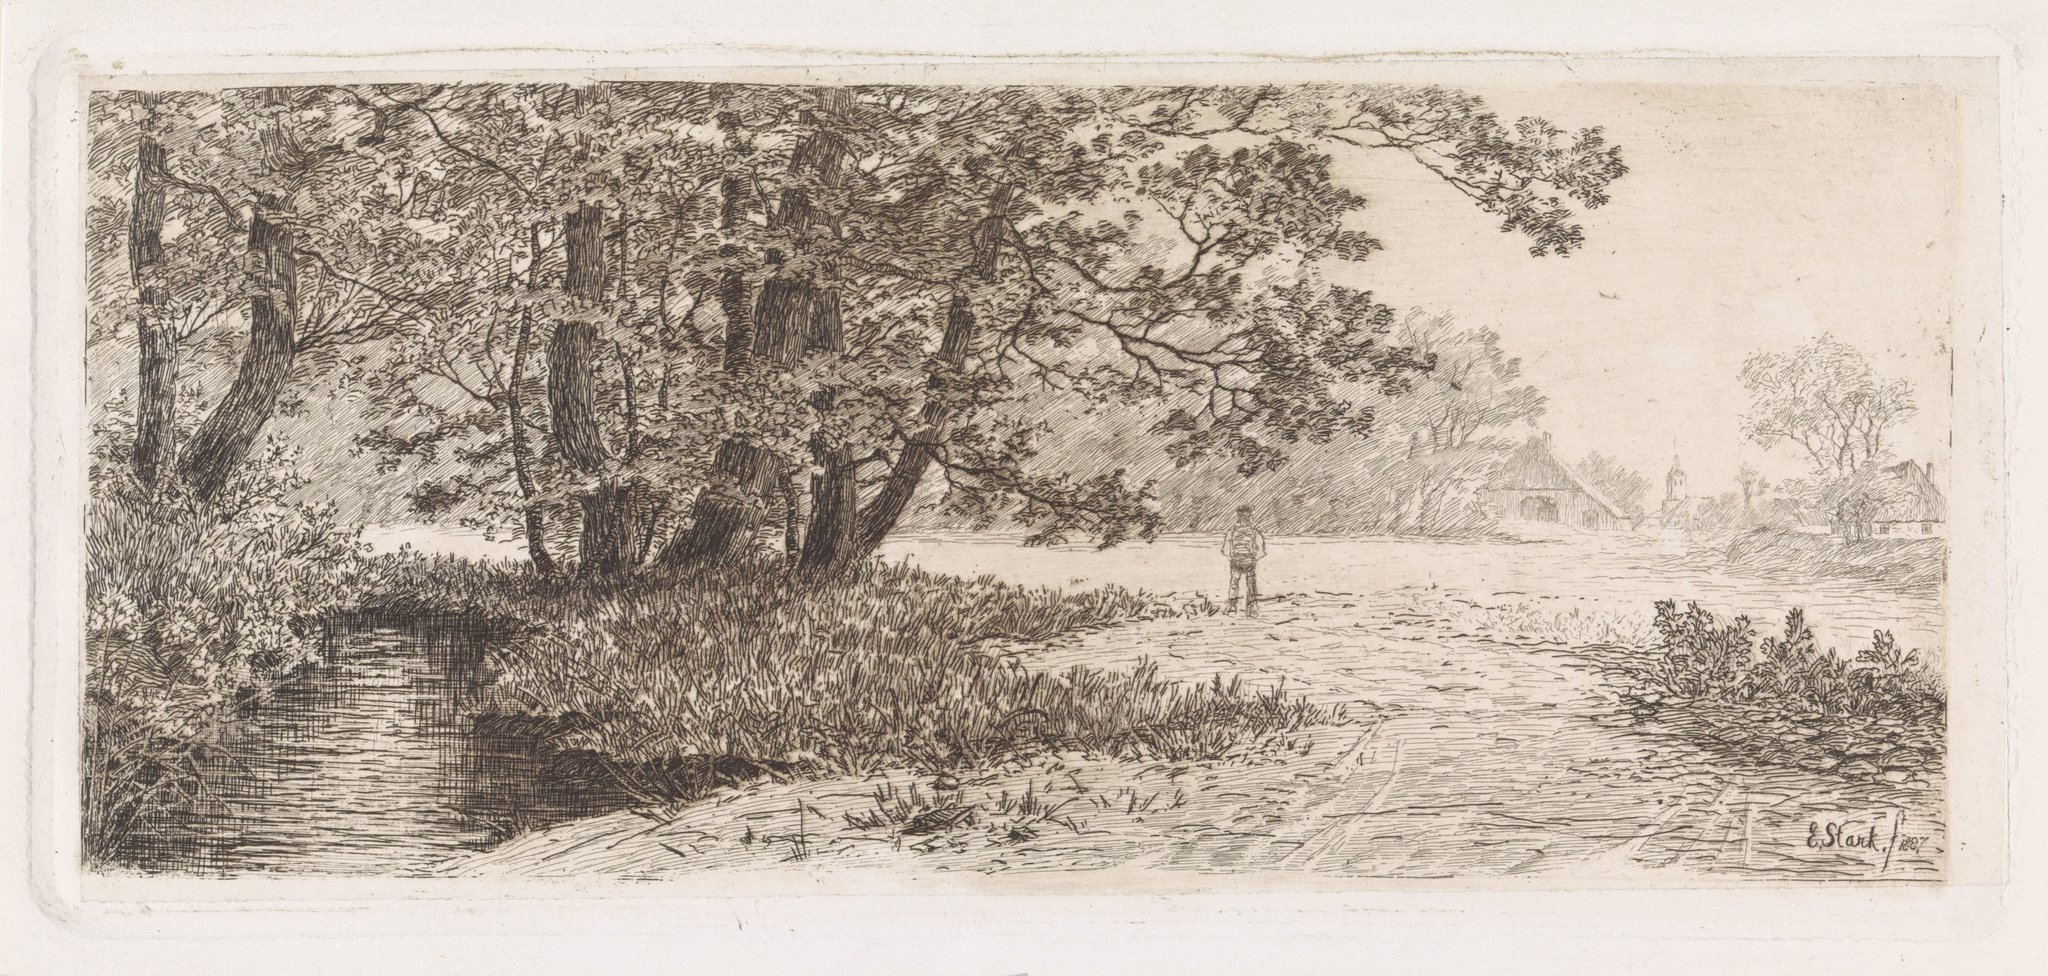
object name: print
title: Landschap met bomen langs het water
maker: elias stark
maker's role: draughtsman, print maker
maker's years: 1849-1933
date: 1887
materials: paper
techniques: etching, intaglio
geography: nieuwer-amstel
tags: landscapes in the temperate zone, groups of trees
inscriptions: collector's mark: Lugt 2228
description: Landschap met links bomen langs een sloot. Rechts op de achtergrond een man op de rug gezien en een dorp.